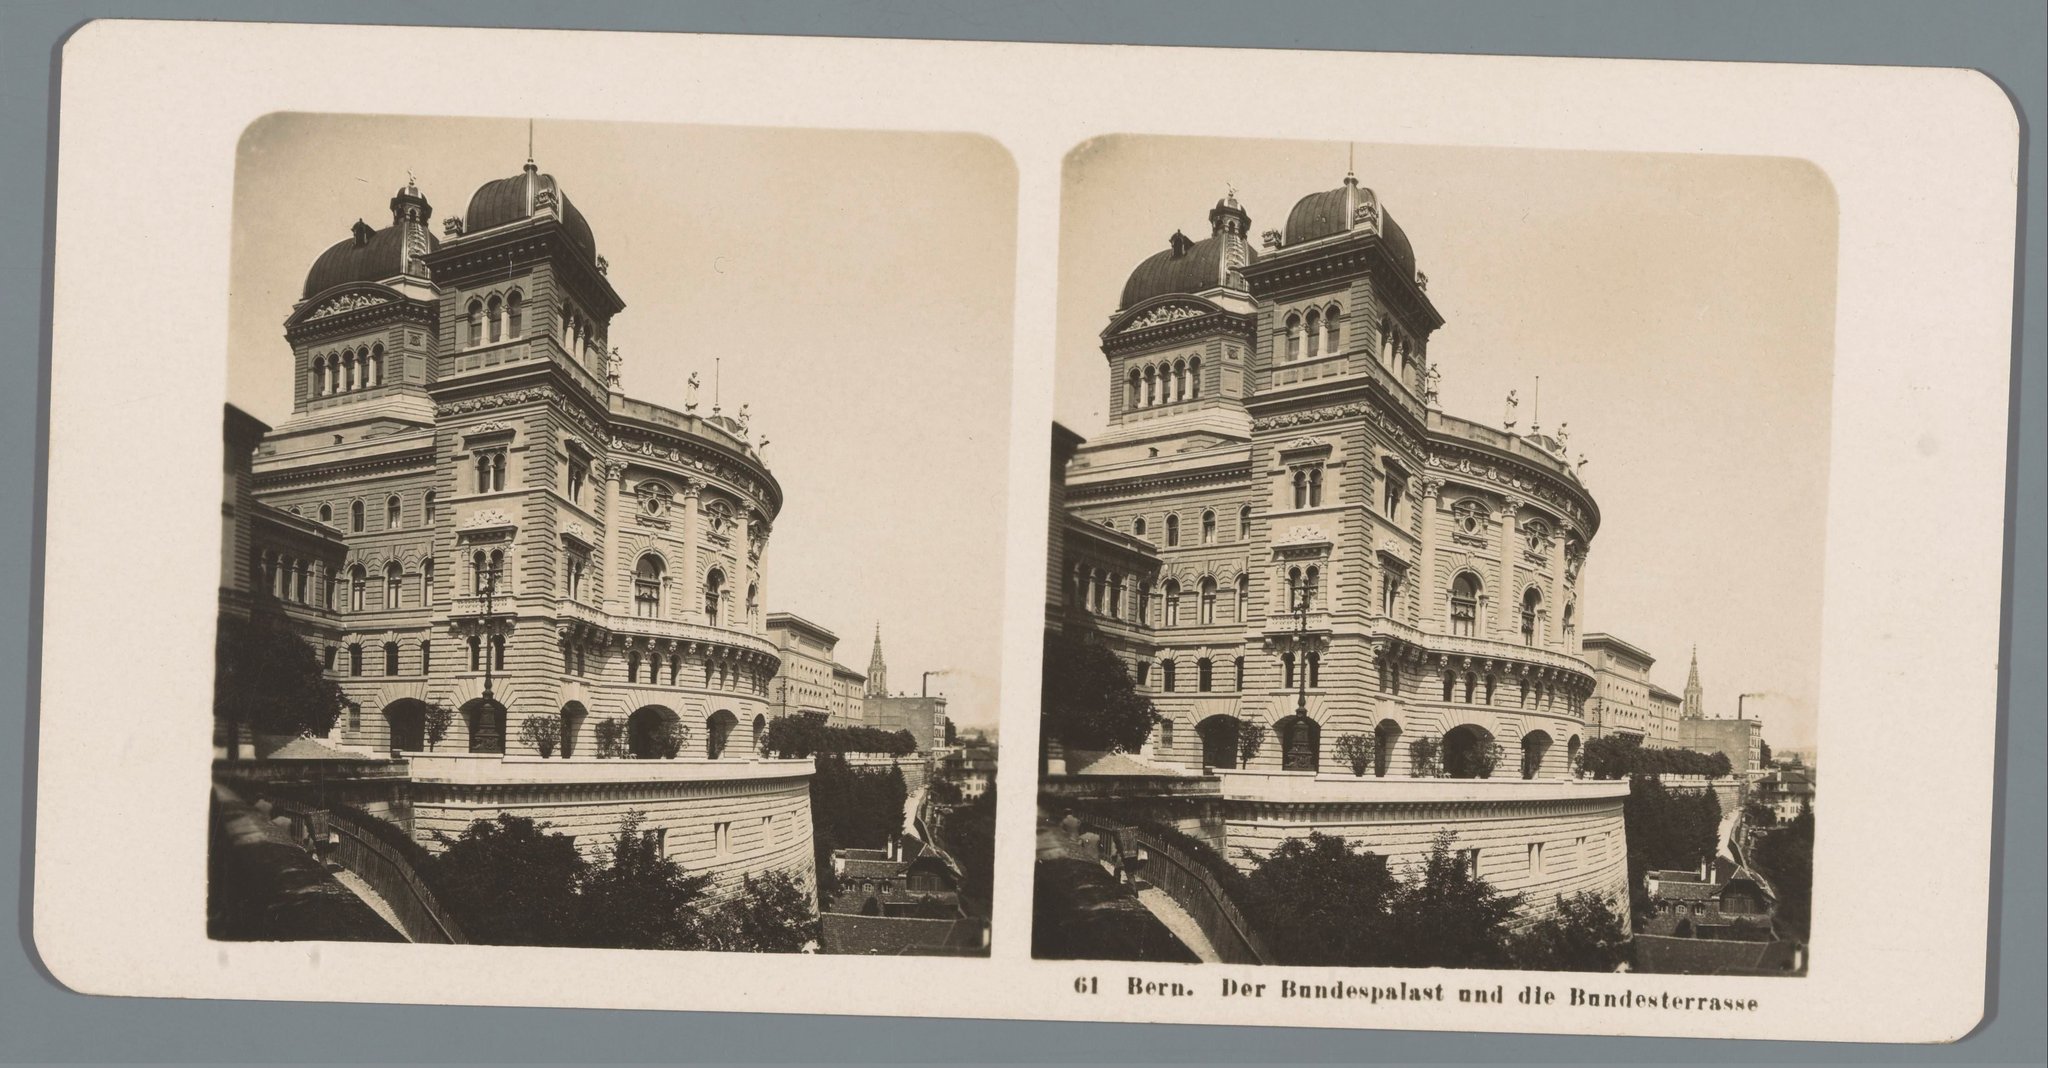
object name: stereograph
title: Bern. Der Bundespalast und die Bundesterrasse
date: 1906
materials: cardboard, photographic support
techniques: gelatin silver print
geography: bern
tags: façade (of house or building), lower house, parliament, chamber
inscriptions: inscription: ‘Neue Photographische Gesellschaft A. G., Steglitz-Berlin. 1906.’, number: ‘61’